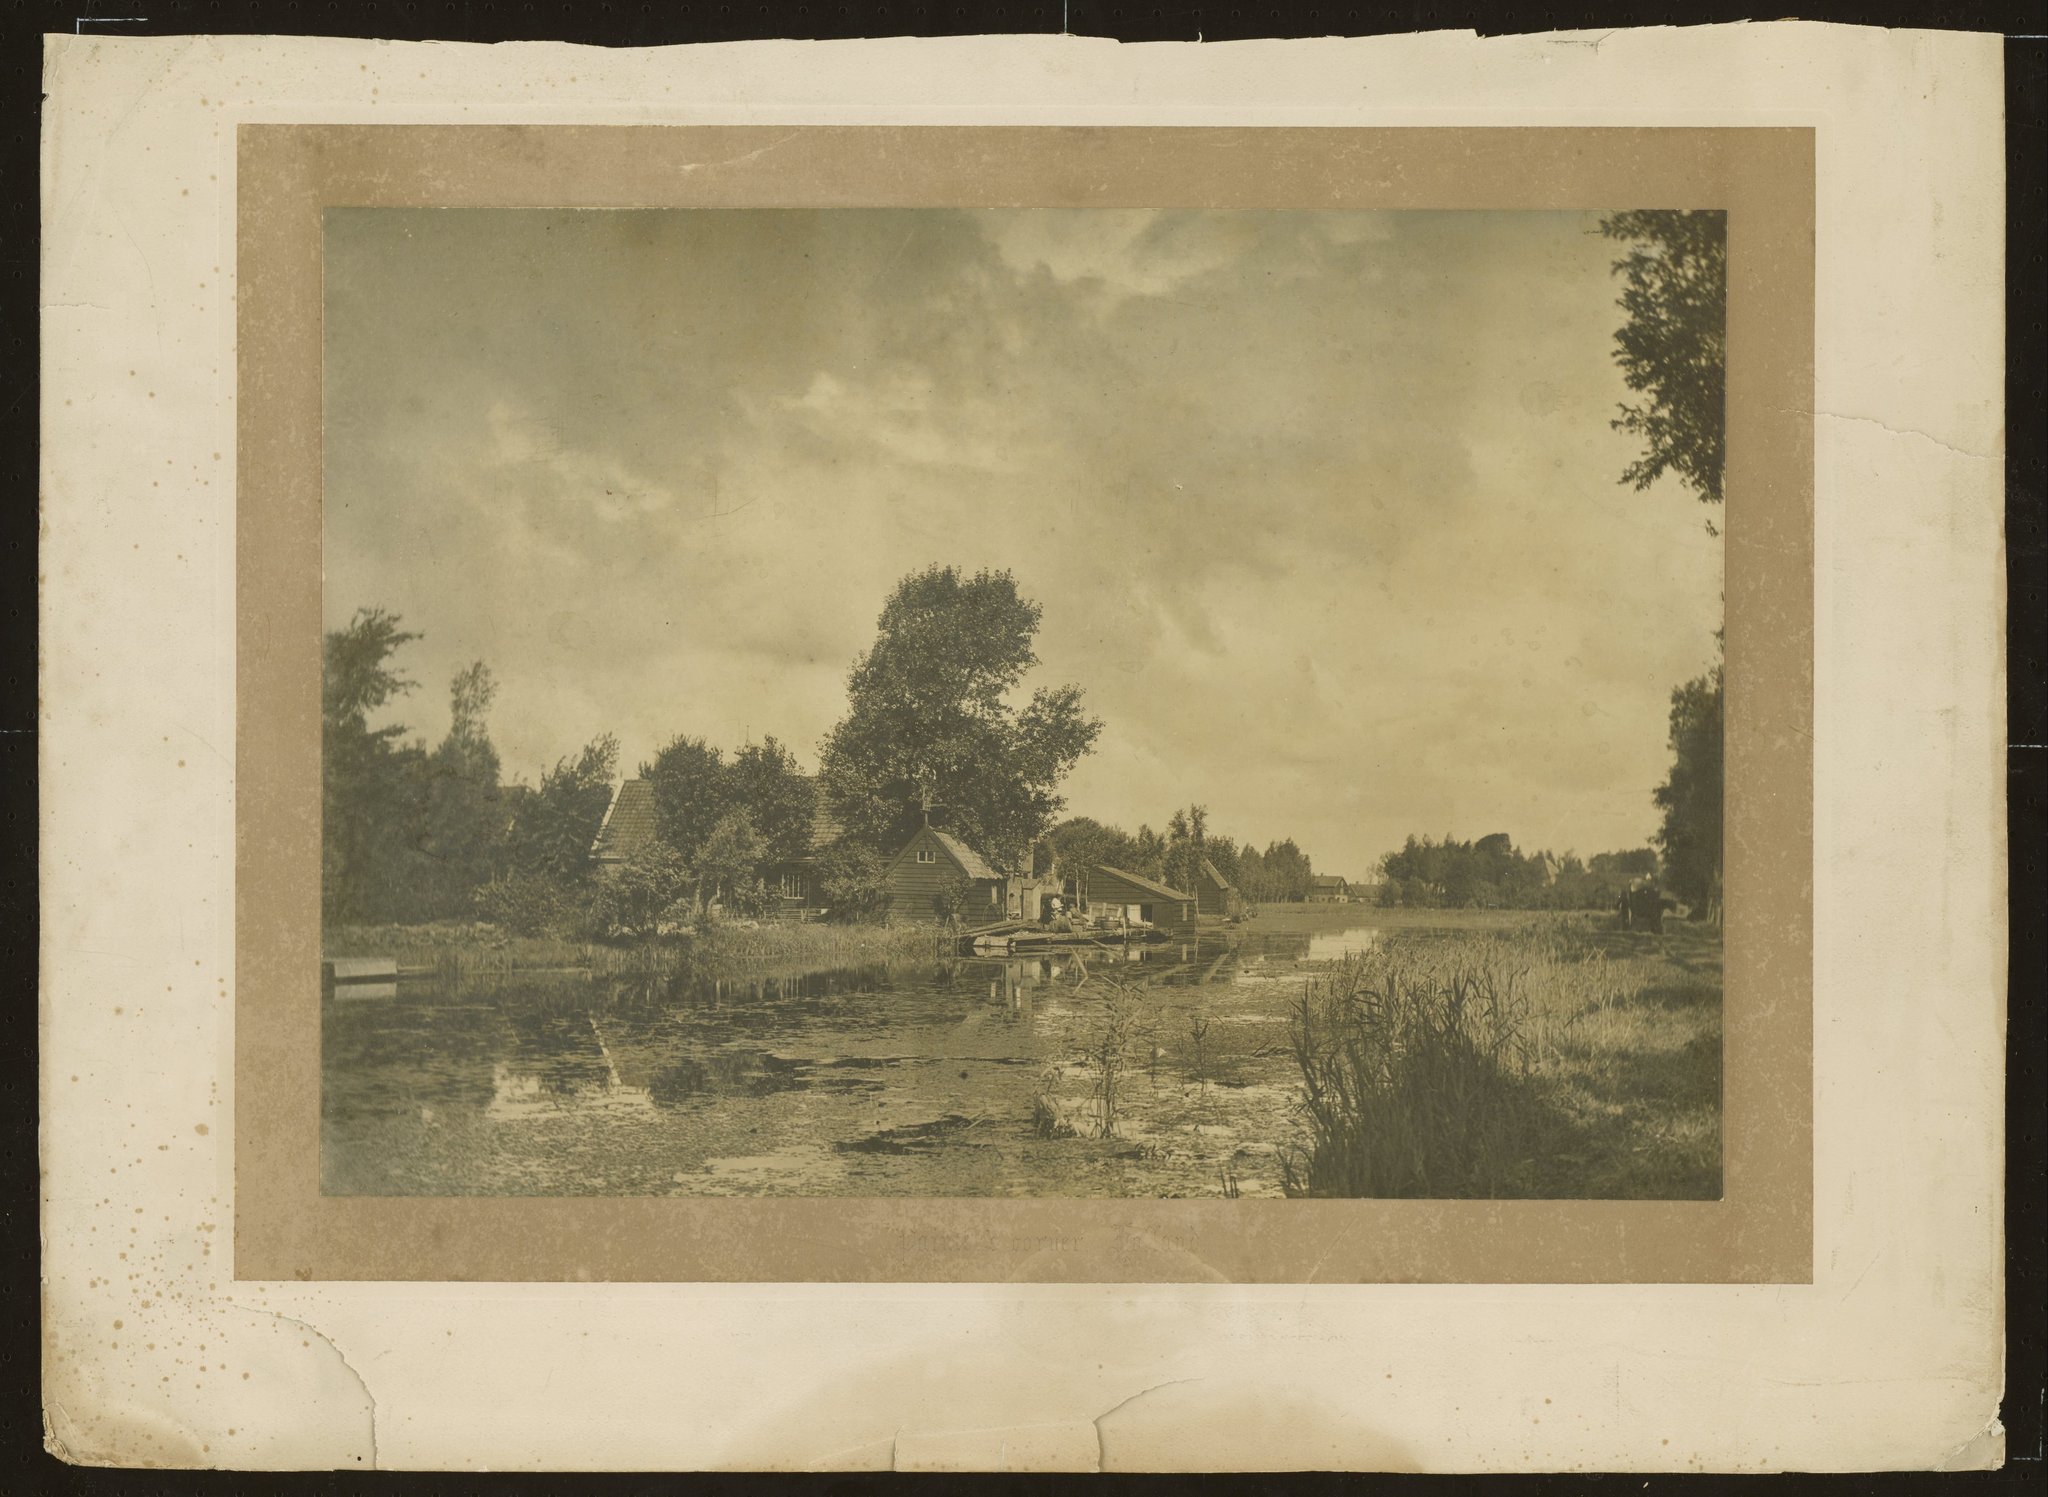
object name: photograph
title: In 't Gein (A Painters Corner), Coin des Peintres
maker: alb. kapteijn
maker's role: amateurfotograaf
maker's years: 1848-1927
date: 1894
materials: cardboard, paper, photographic support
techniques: gelatin silver print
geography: netherlands